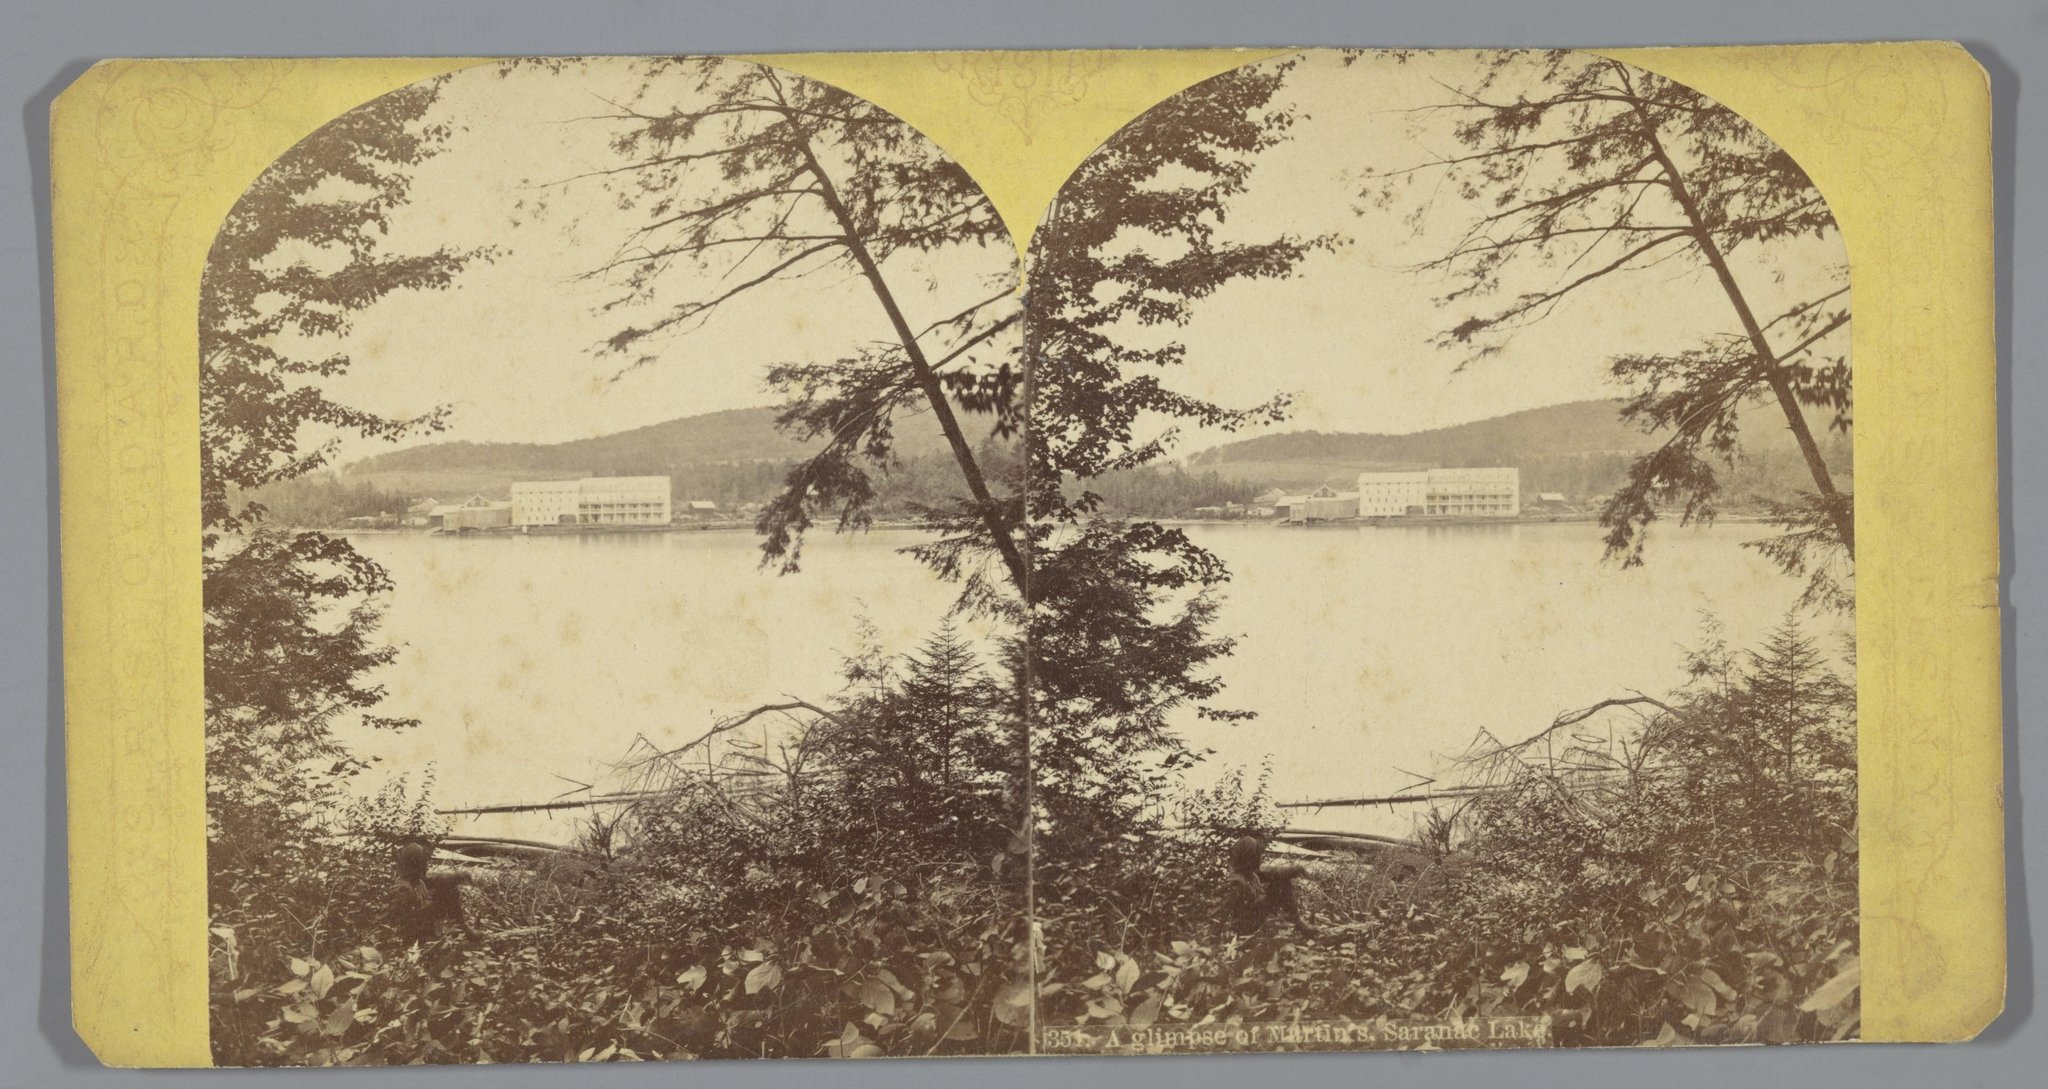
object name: stereograph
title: A glimpse of Martin's, Saranac Lake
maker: seneca ray stoddard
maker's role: fotograaf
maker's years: 1843-1917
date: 1870-1888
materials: cardboard, paper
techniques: albumen print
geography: saranac lake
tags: lake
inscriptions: : ‘Crystal/ Glens Falls N.Y.’, number: ‘351’